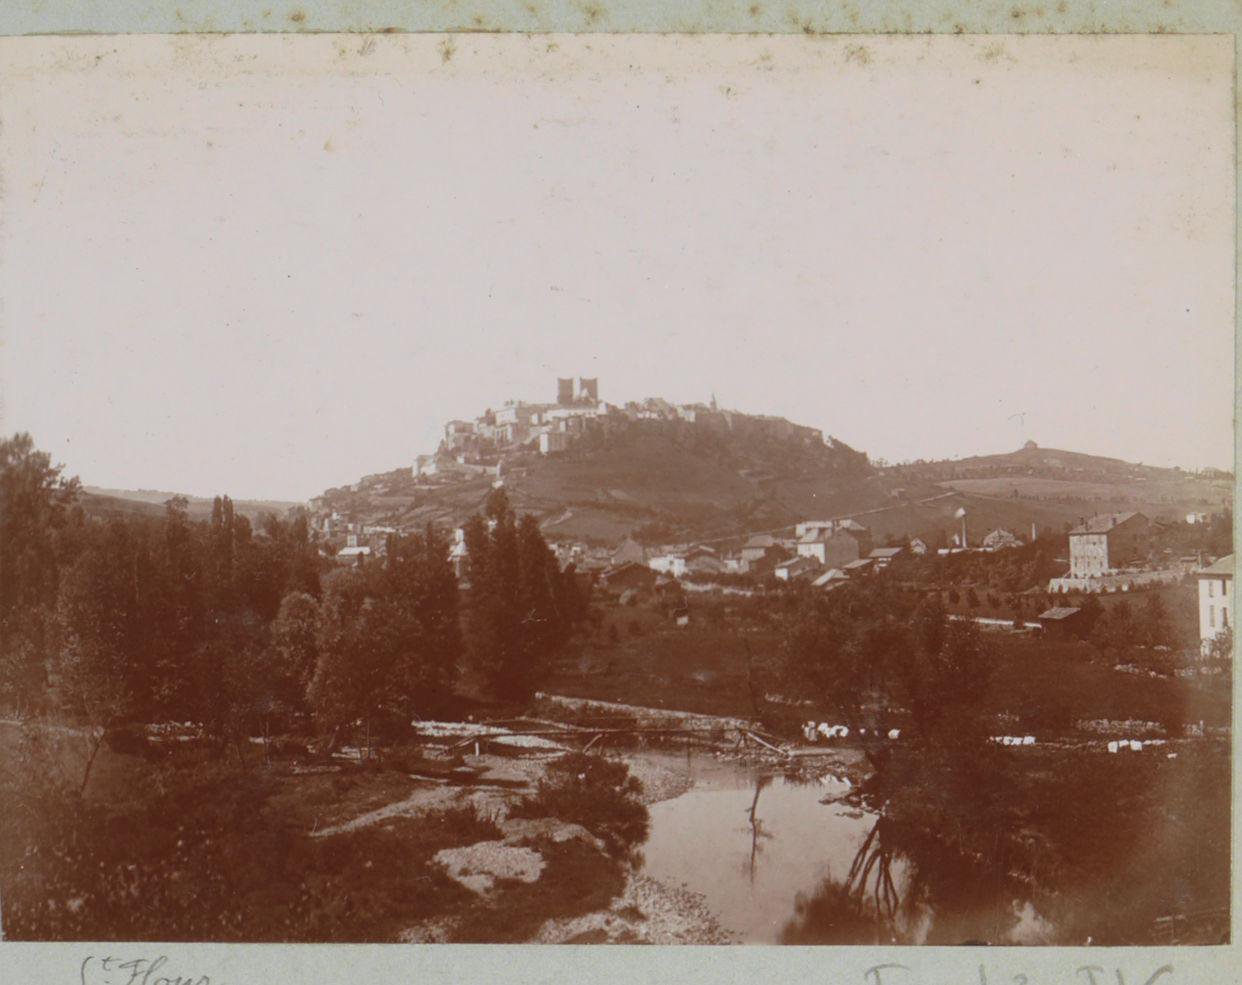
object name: photograph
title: Gezicht op Saint-Flour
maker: delizy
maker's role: manufacturer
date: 1899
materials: paper, photographic support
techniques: gelatin silver print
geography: saint-flour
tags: prospect of village, silhouette of village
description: Onderdeel van Fotoalbum van een Franse amateurfotograaf met opnames van uitstapjes in Frankrijk, Spanje, België, Luxemburg en Nederland, de eerste automobielen en autoraces.